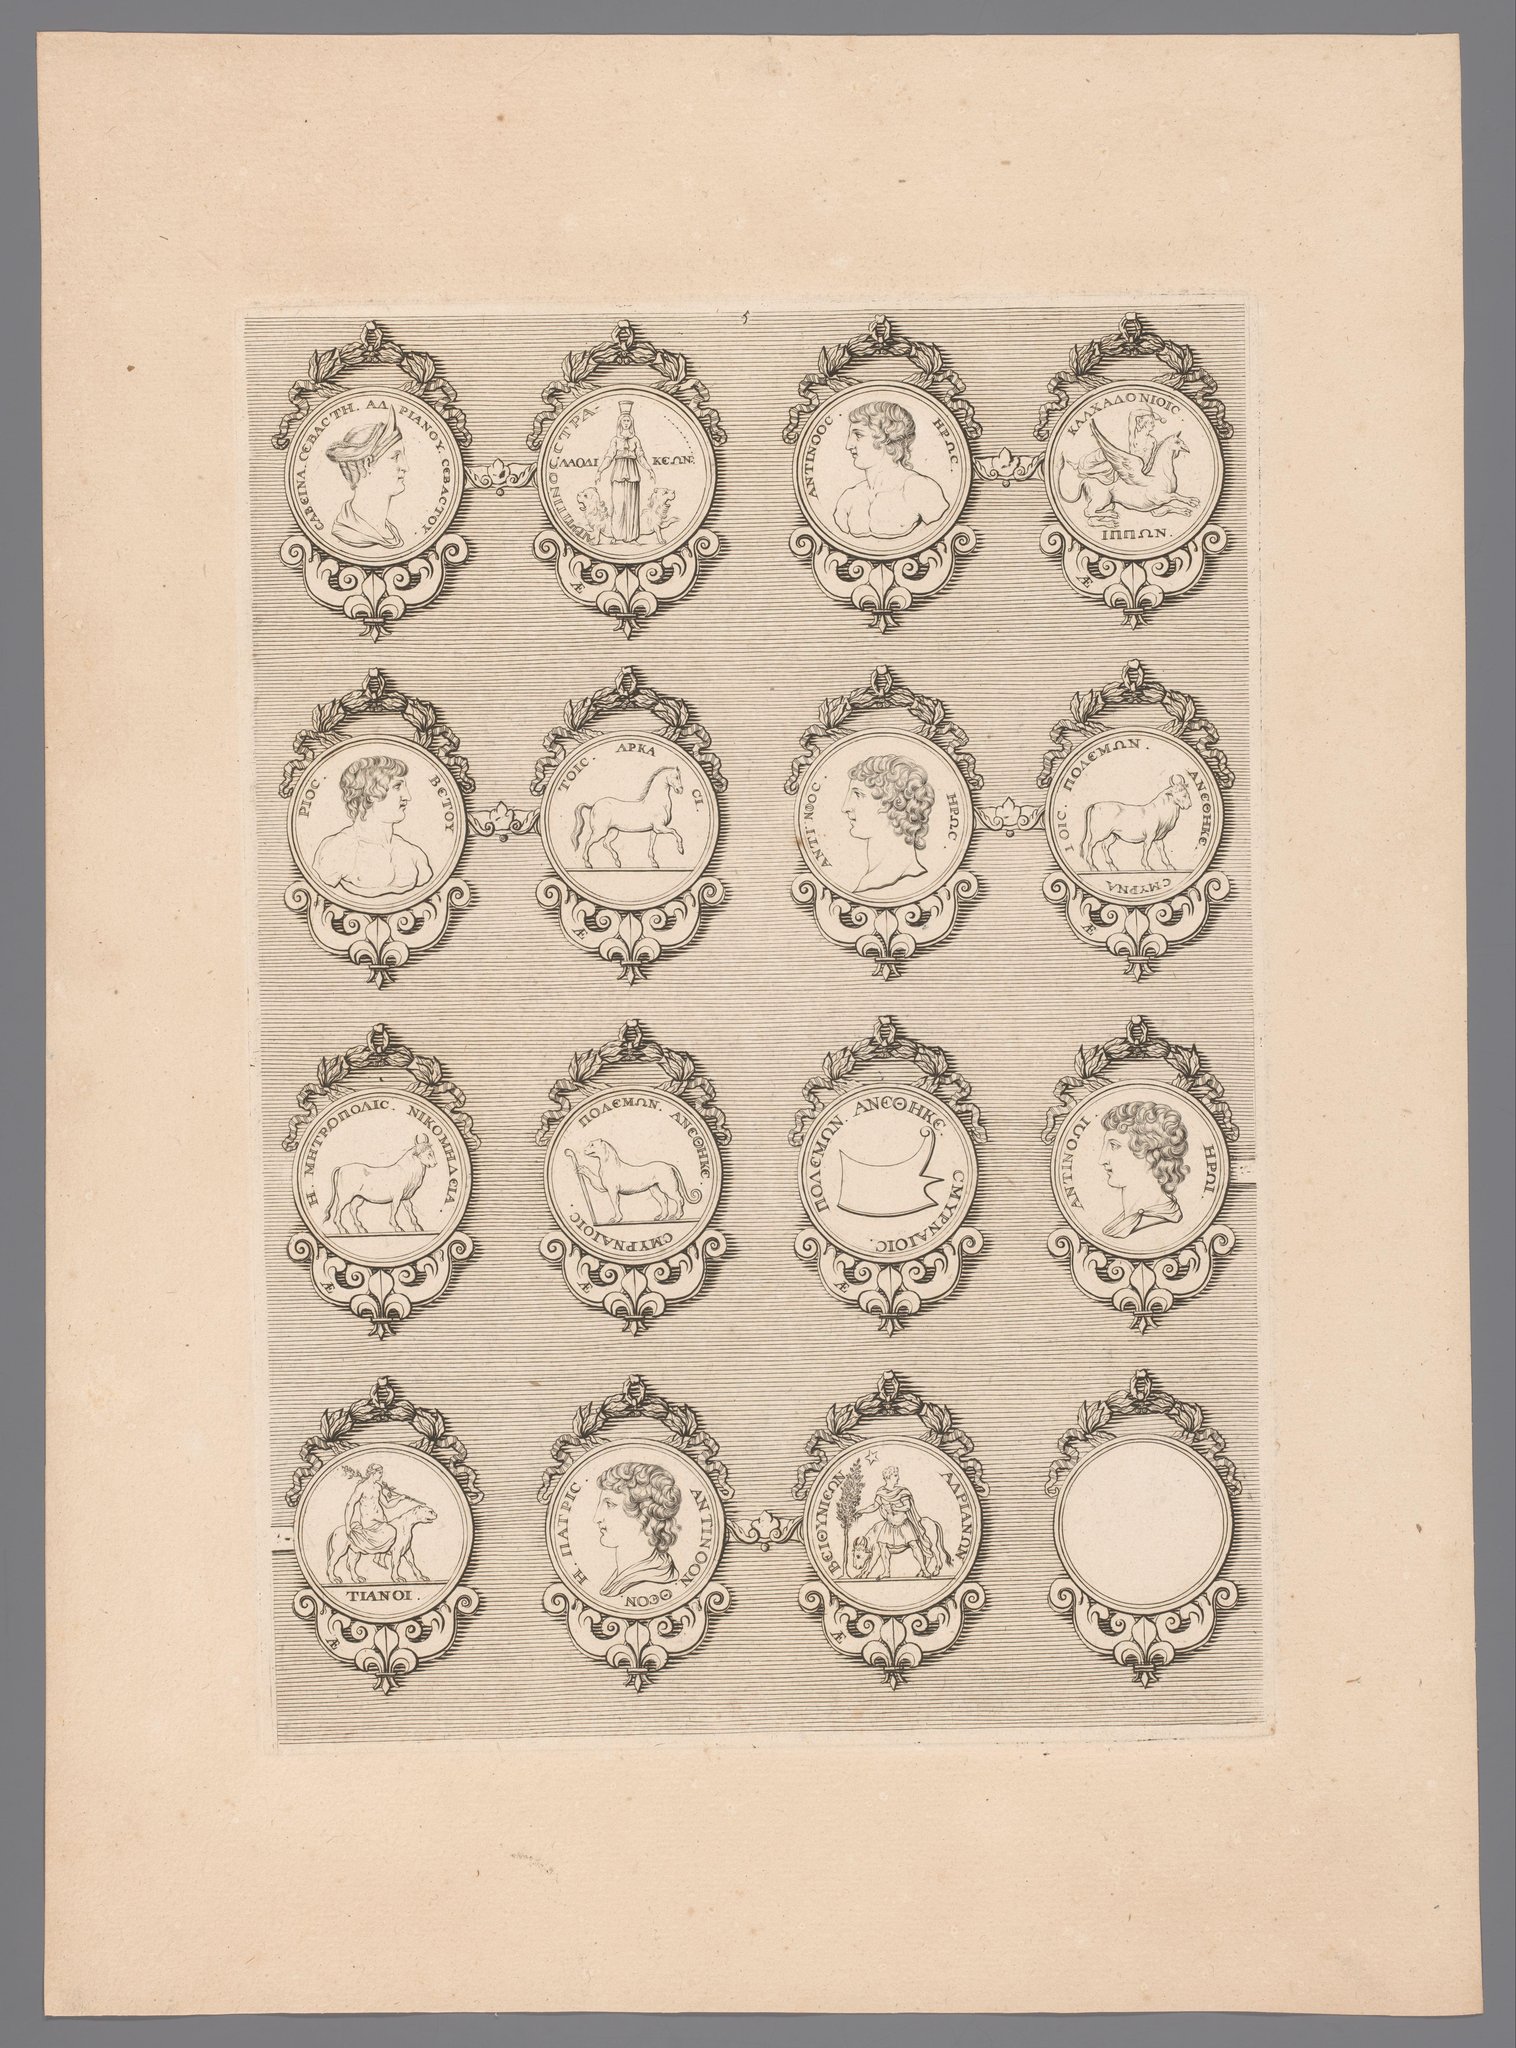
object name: print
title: Penningen in versierde lijsten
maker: simon de la boissière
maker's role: print maker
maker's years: 1637-1682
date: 1647-1682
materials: paper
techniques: etching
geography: france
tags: medal (considered as a piece of sculpture, regardless of its specific function)